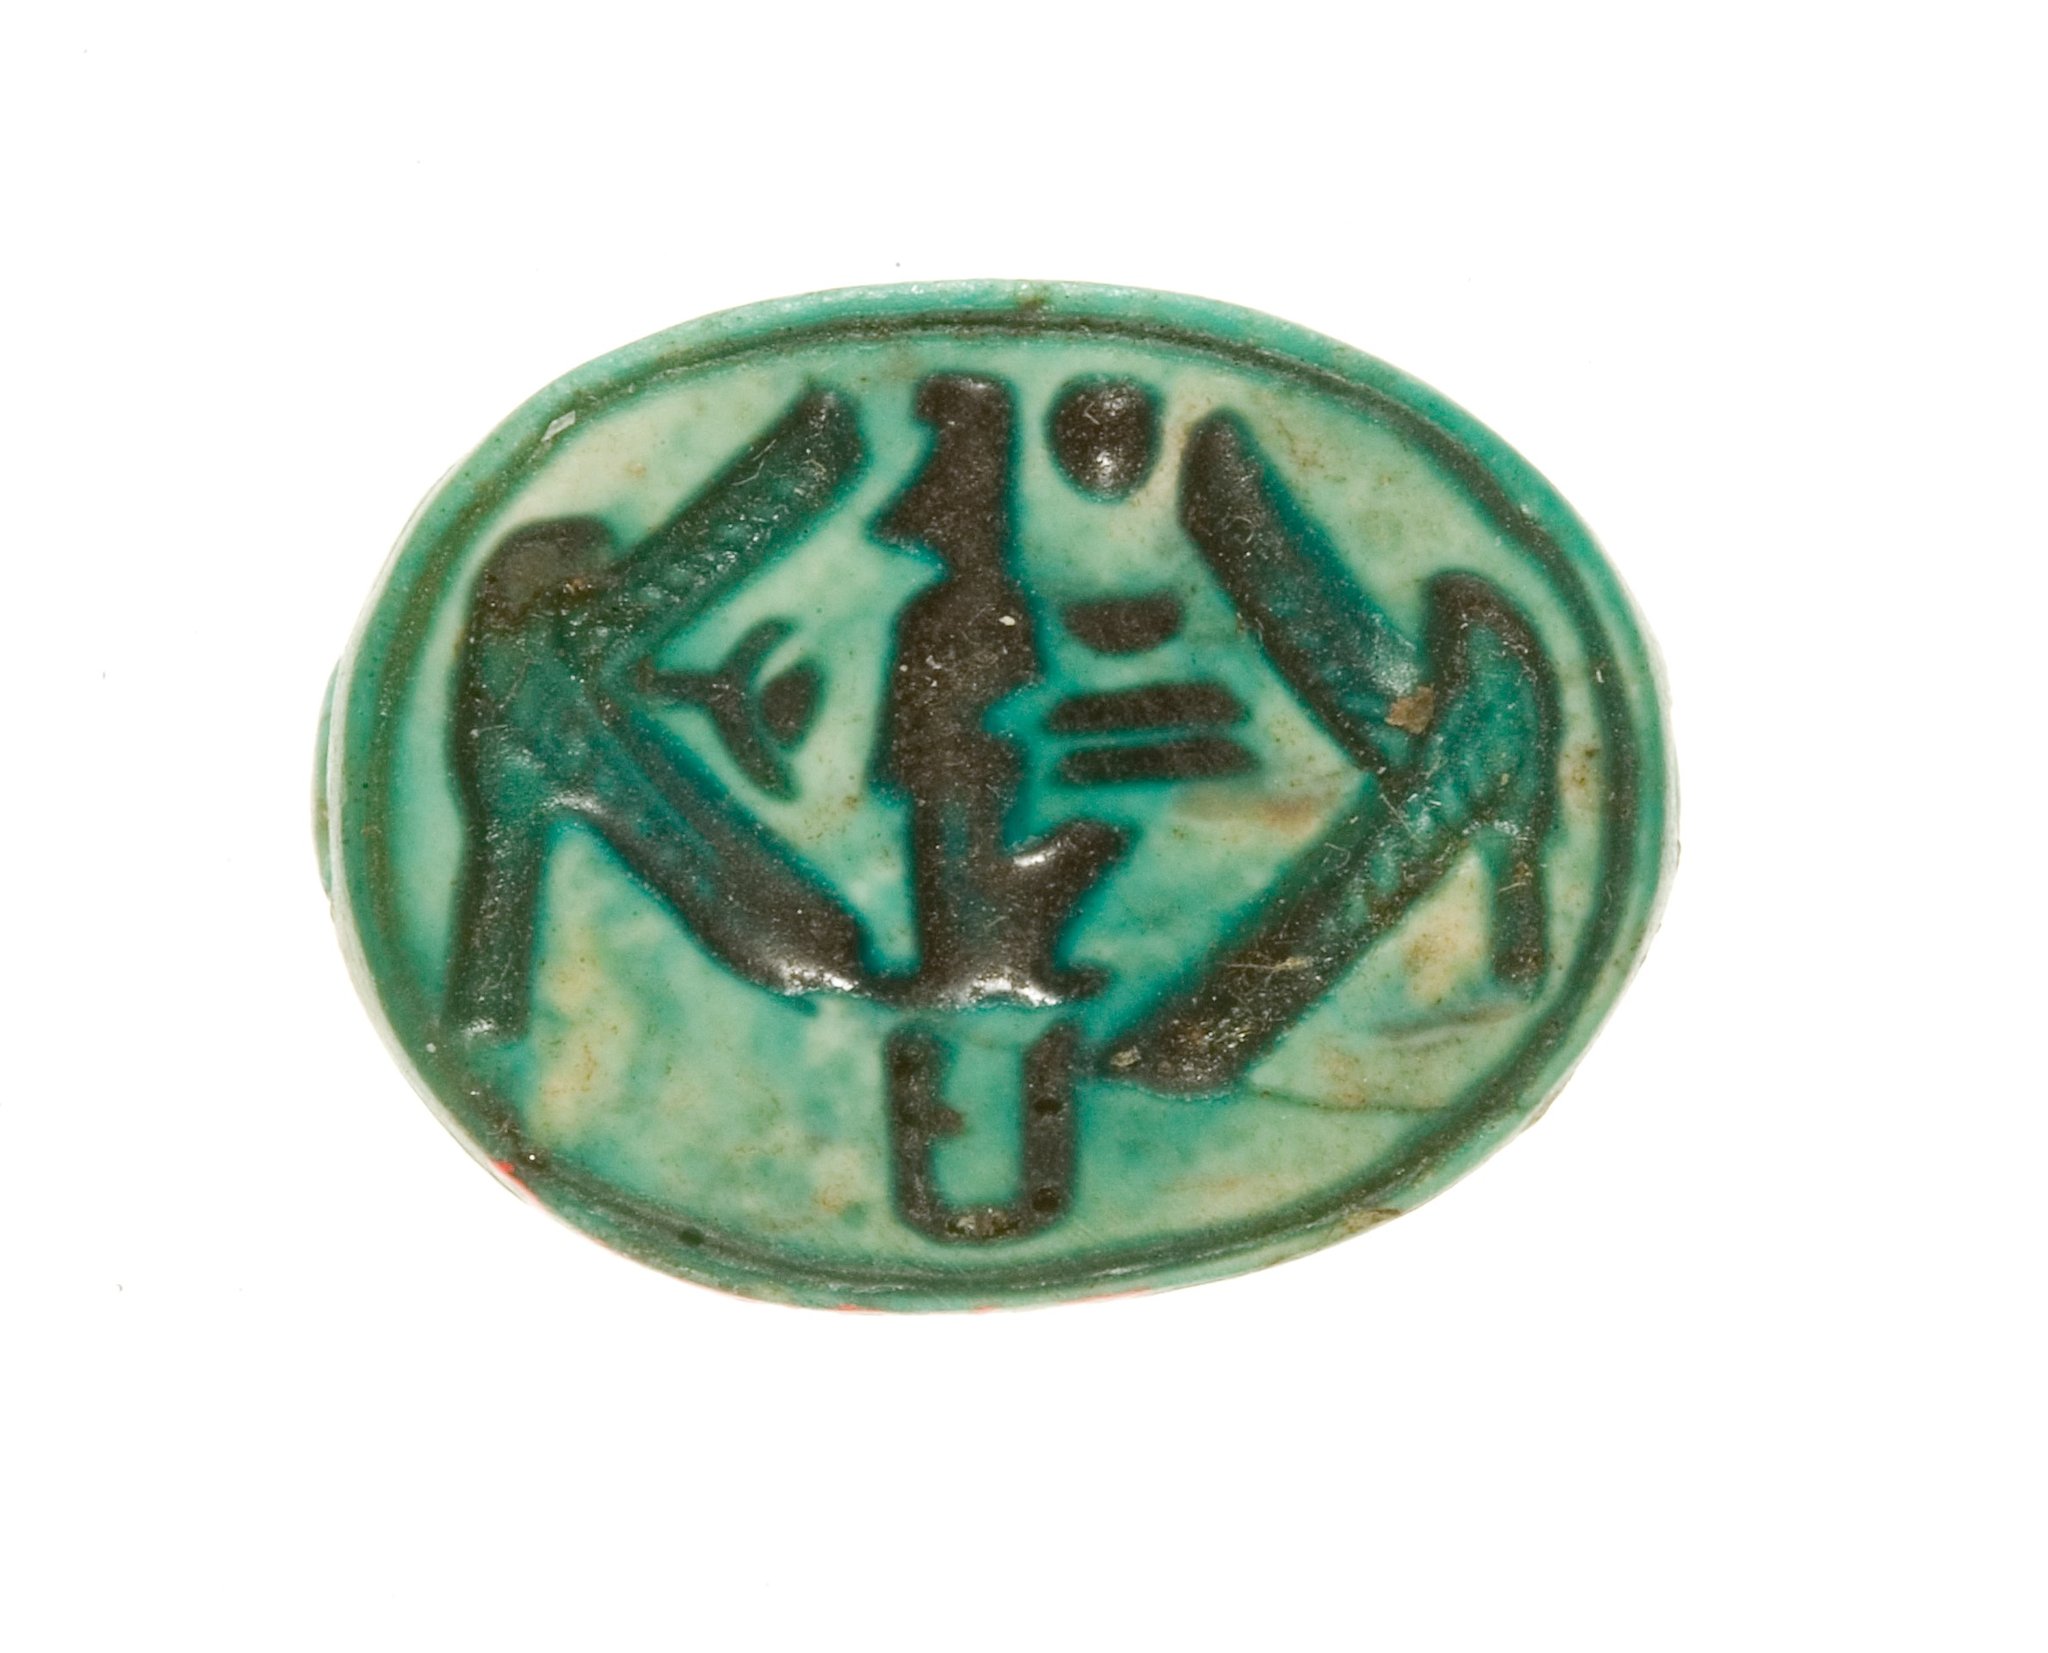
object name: scarab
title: Scarab Inscribed Lord of the Two Lands Maatkare Flanked by Falcons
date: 1479-1458 BCE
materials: stone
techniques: glazing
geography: egypt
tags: falcons,hieroglyphs,scarabs